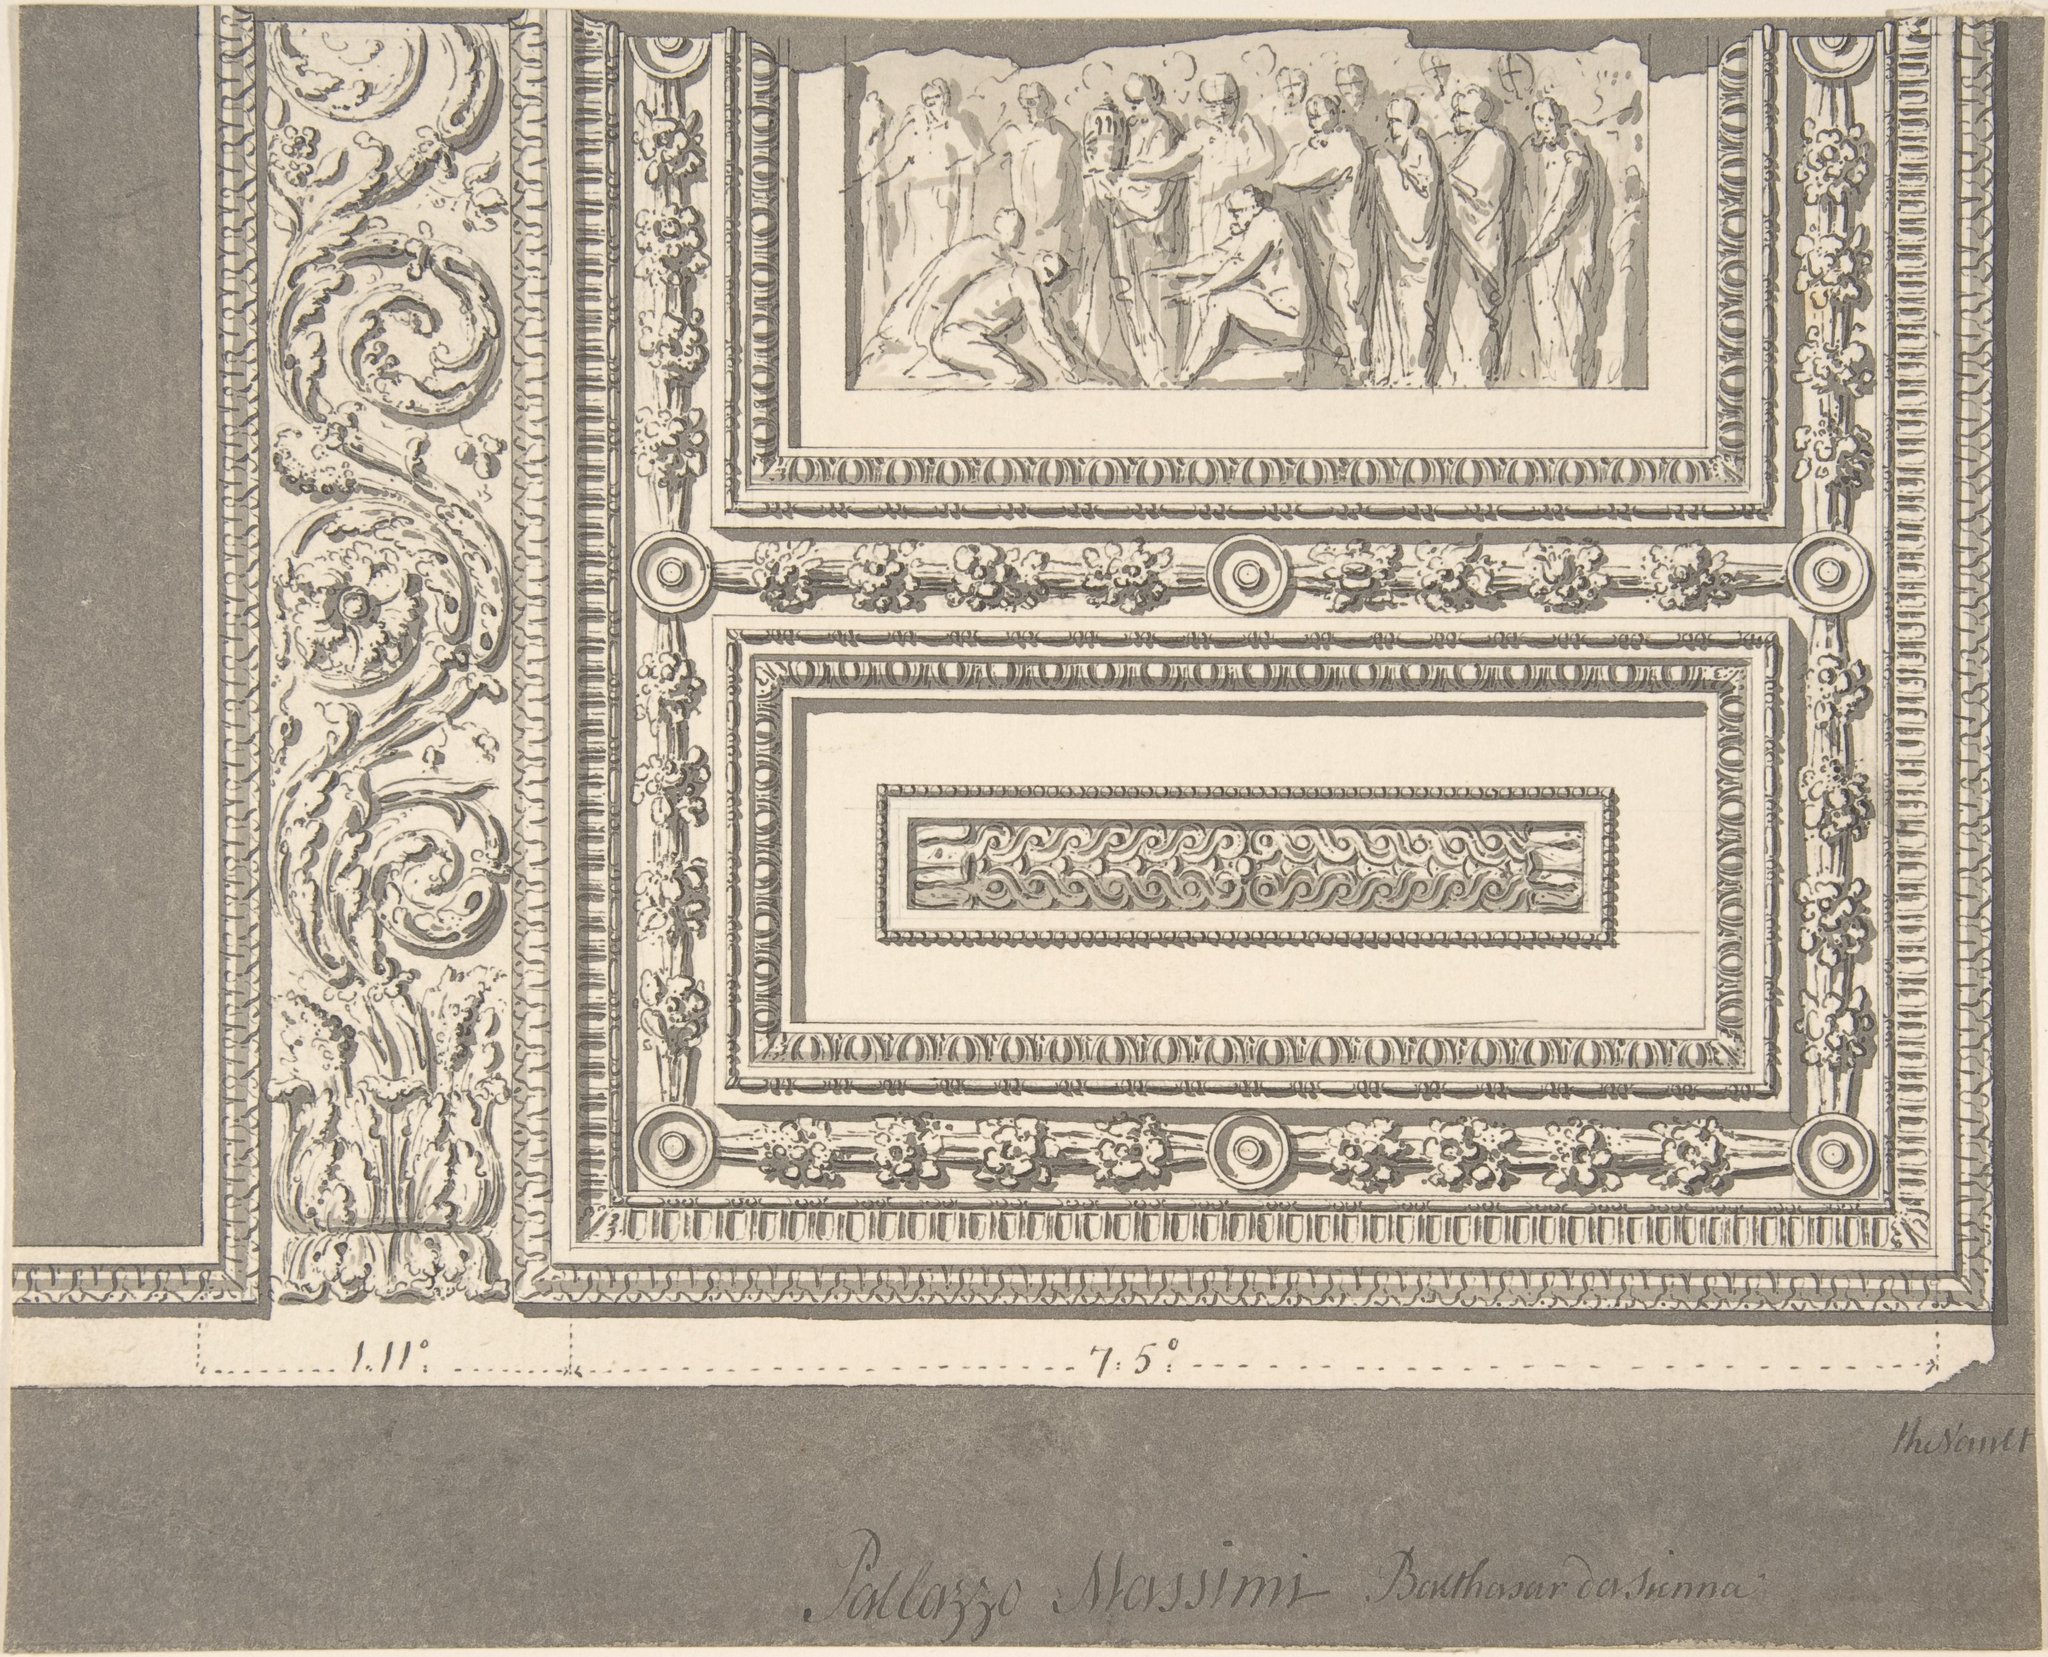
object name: drawing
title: Detail of Ceiling, Palazzo Massimi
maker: sir william chambers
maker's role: artist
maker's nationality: british, born sweden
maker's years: 1723-1796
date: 1750-1755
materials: ink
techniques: brush, pen, wash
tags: ceilings